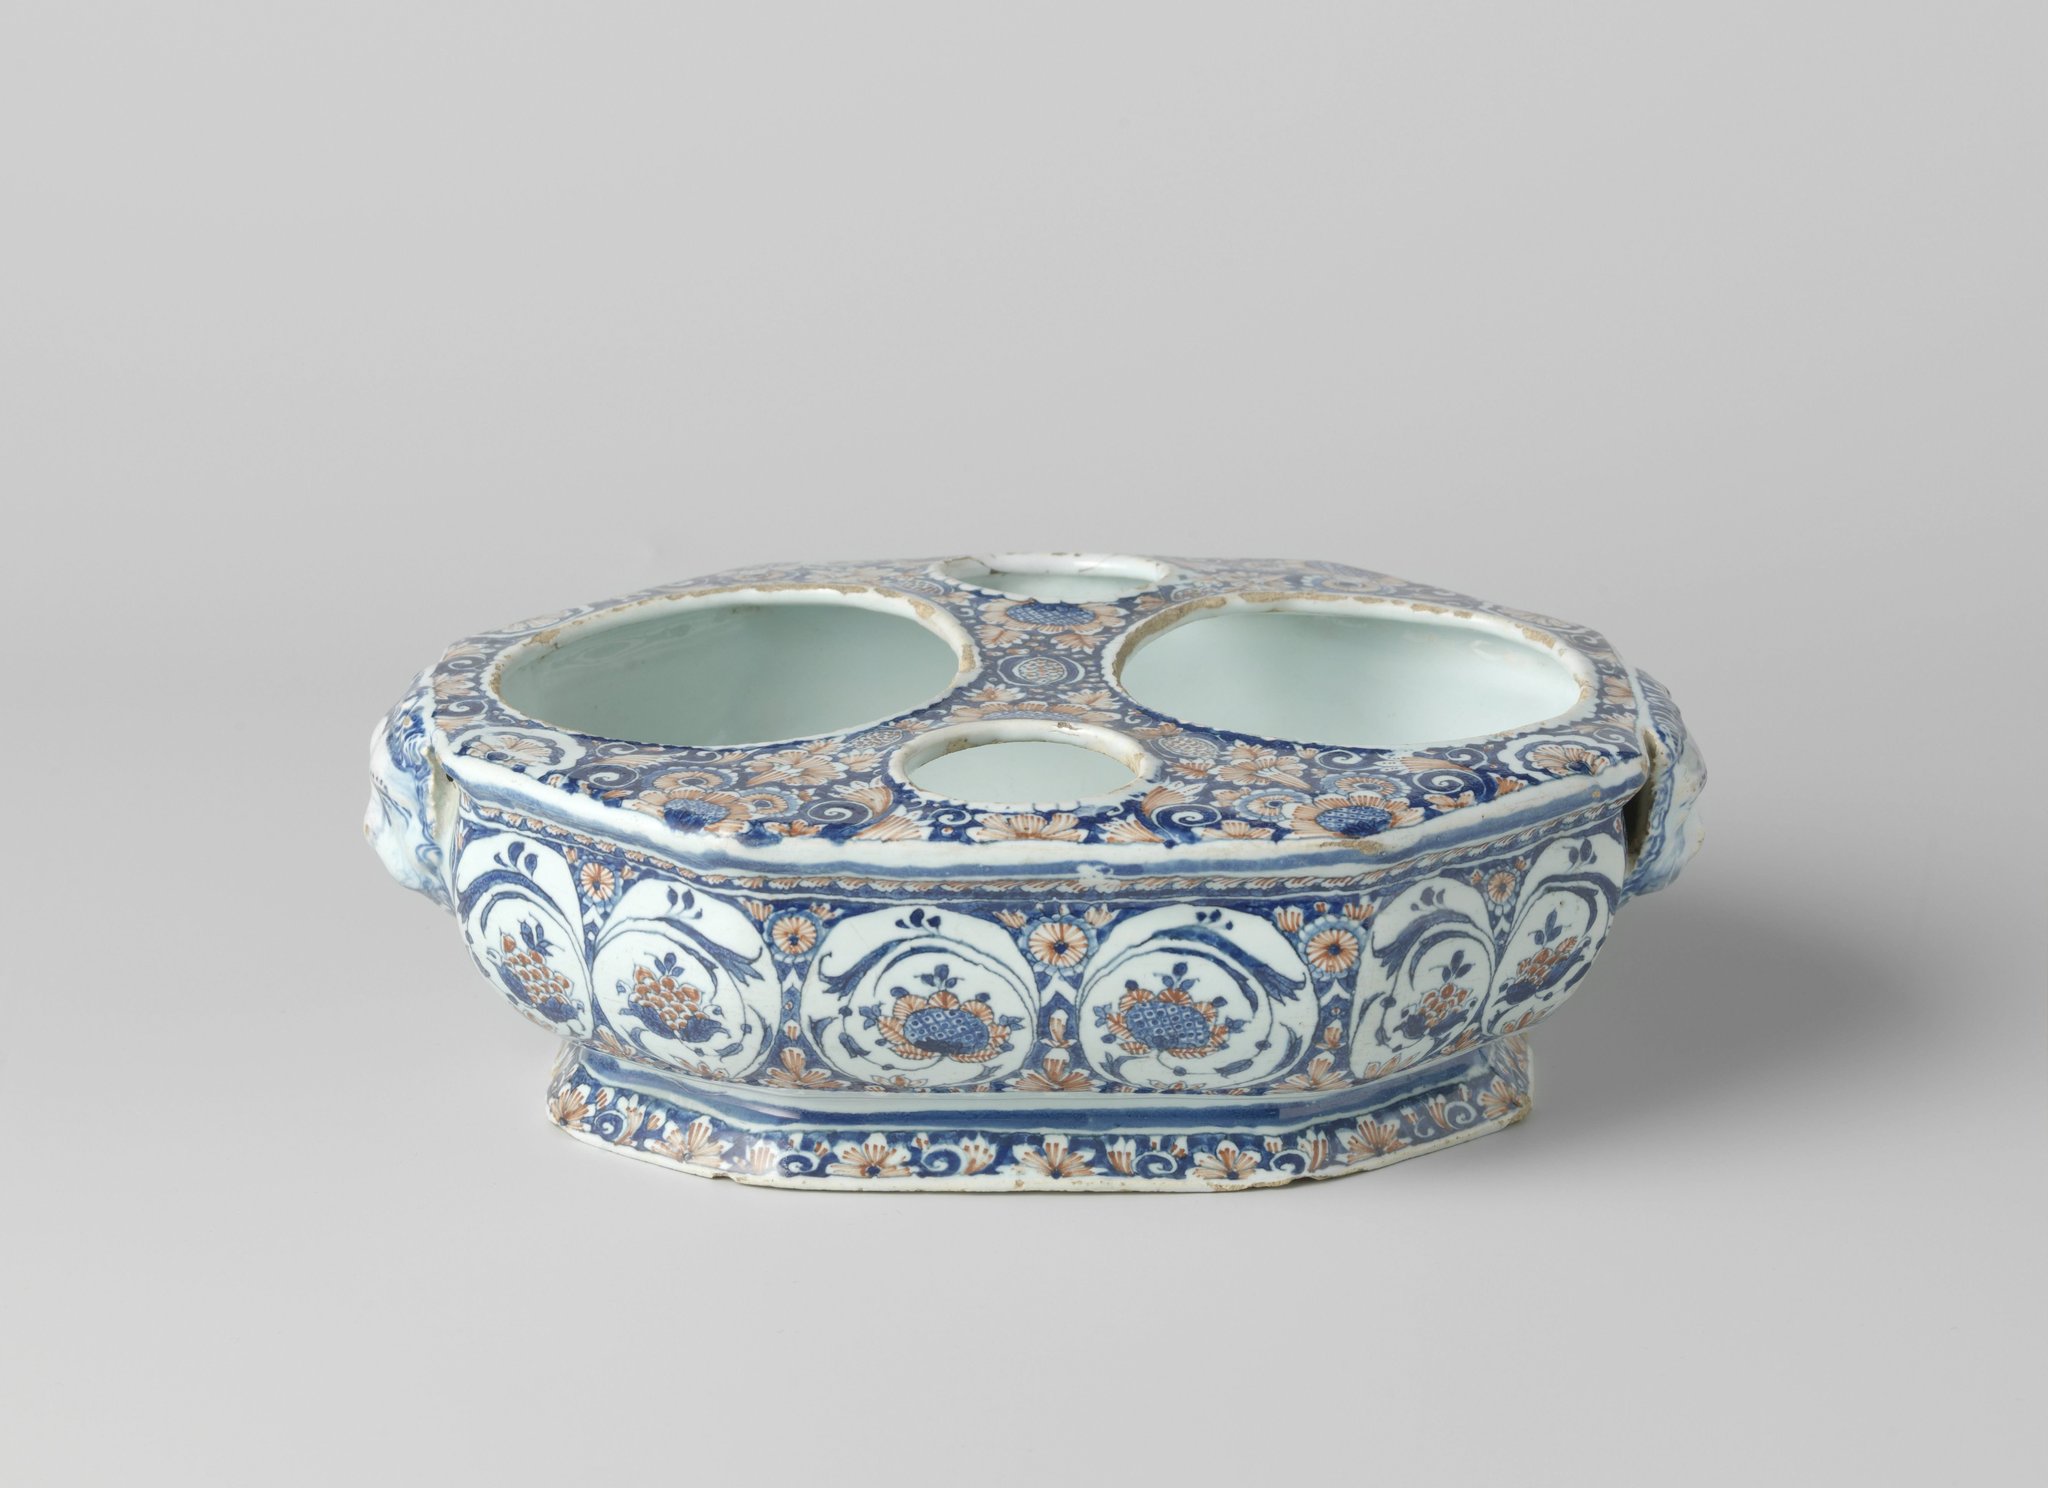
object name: cruet set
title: Olie- en azijnstel met leeuwenkoppen in reliëf, beschilderd met guirlandes en bloemen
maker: guillibaud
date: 1720-1750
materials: earthenware, glaze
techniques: painted, polychromy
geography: rouen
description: Achtkantig, langwerpig olie- en azijnstel van veelkleurig beschilderde faience. Aan de smalle einden zijn leeuwenkoppen in releief bevestigd. Het stel is beschilderd met guirlandes en gestileerde bloemen. De flessen ontbreken. Het stel is gemerkt: G.C.